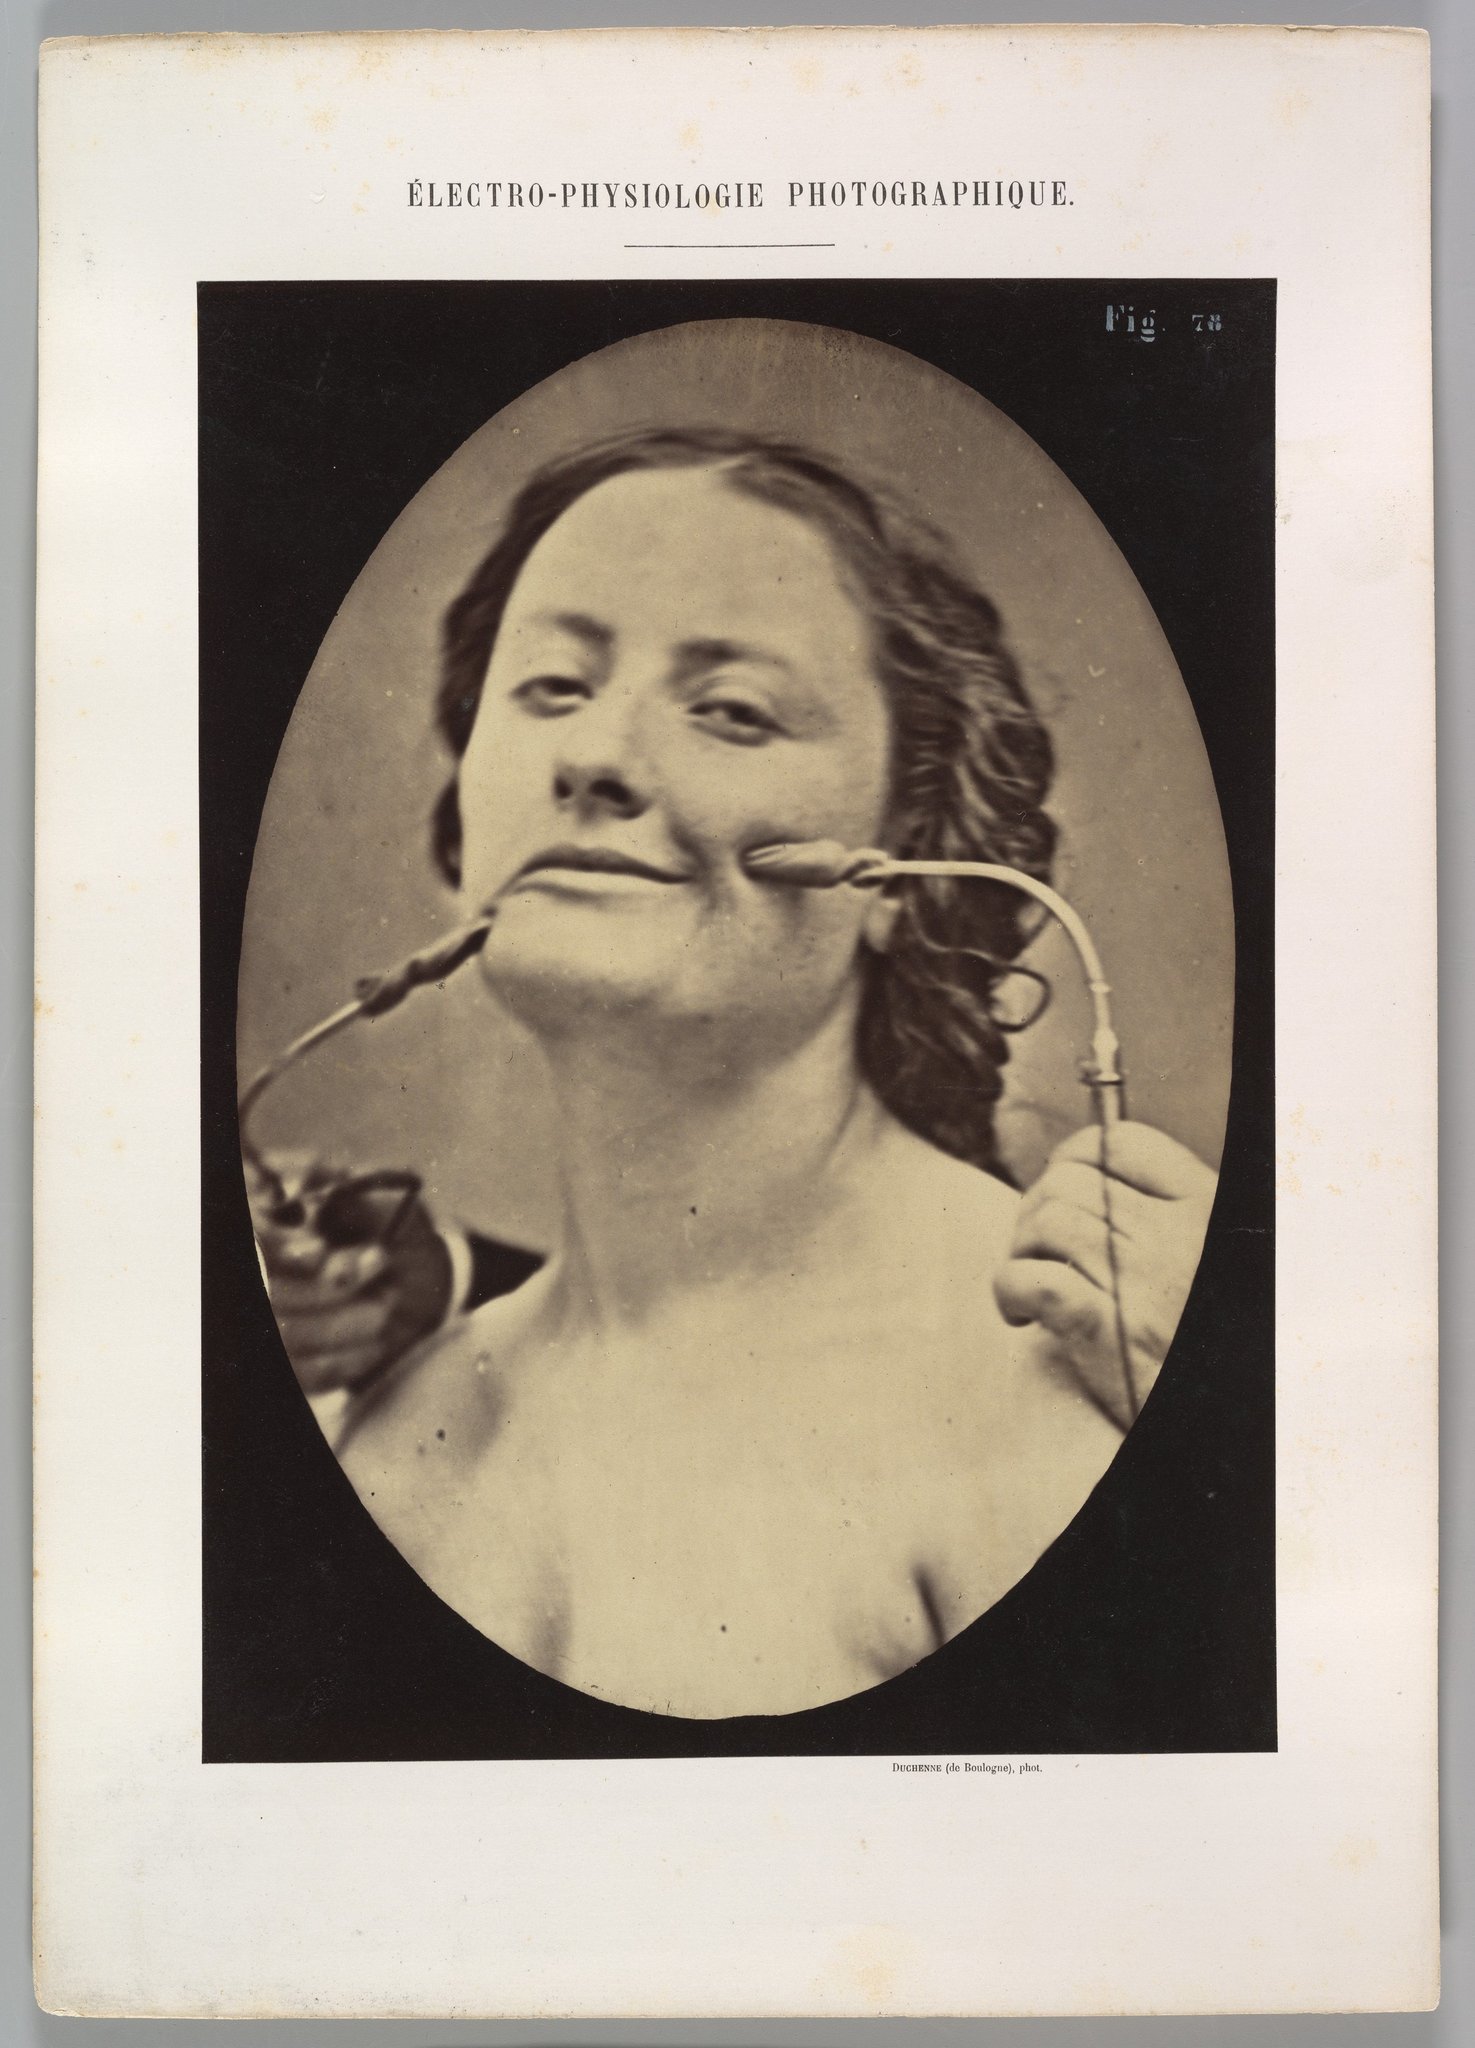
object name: photograph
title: Figure 78: Scene of coquetry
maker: guillaume-benjamin-amand duchenne de boulogne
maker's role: artist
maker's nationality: french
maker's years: 1806-1875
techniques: albumen silver print, glass negative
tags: science,portraits,women